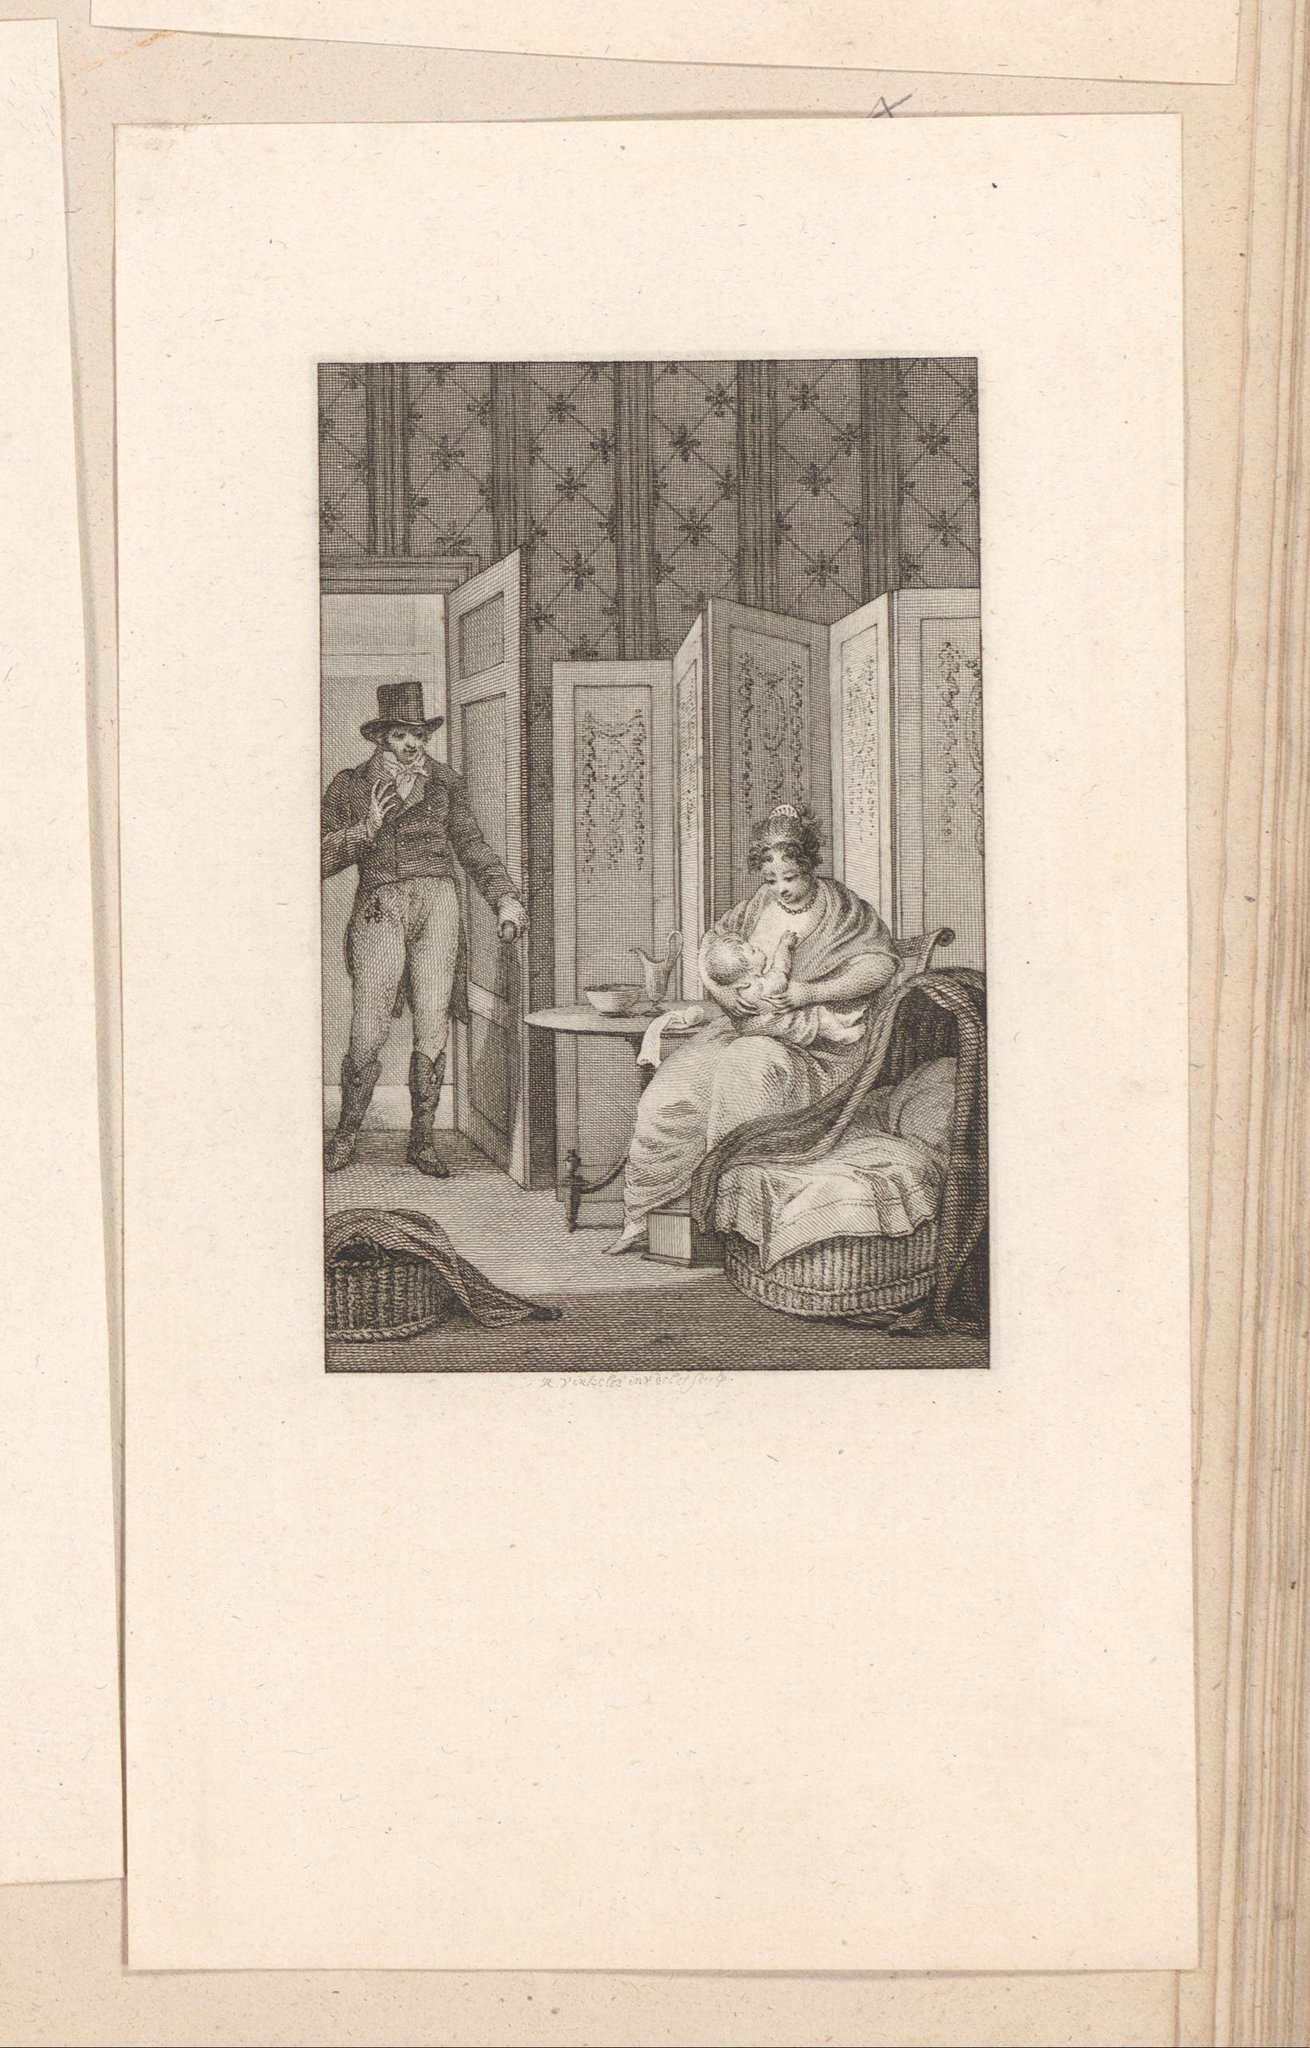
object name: book illustration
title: Moeder met kind voor een kamerscherm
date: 1809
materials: paper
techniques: engraving, etching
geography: haarlem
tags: adult woman, mother and baby or young child, father-love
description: In een vertrek zit een moeder met haar kind op schoot. In de deuropening staat een man. Achter de vrouw een kamerscherm. De prent maakt deel uit van een album.